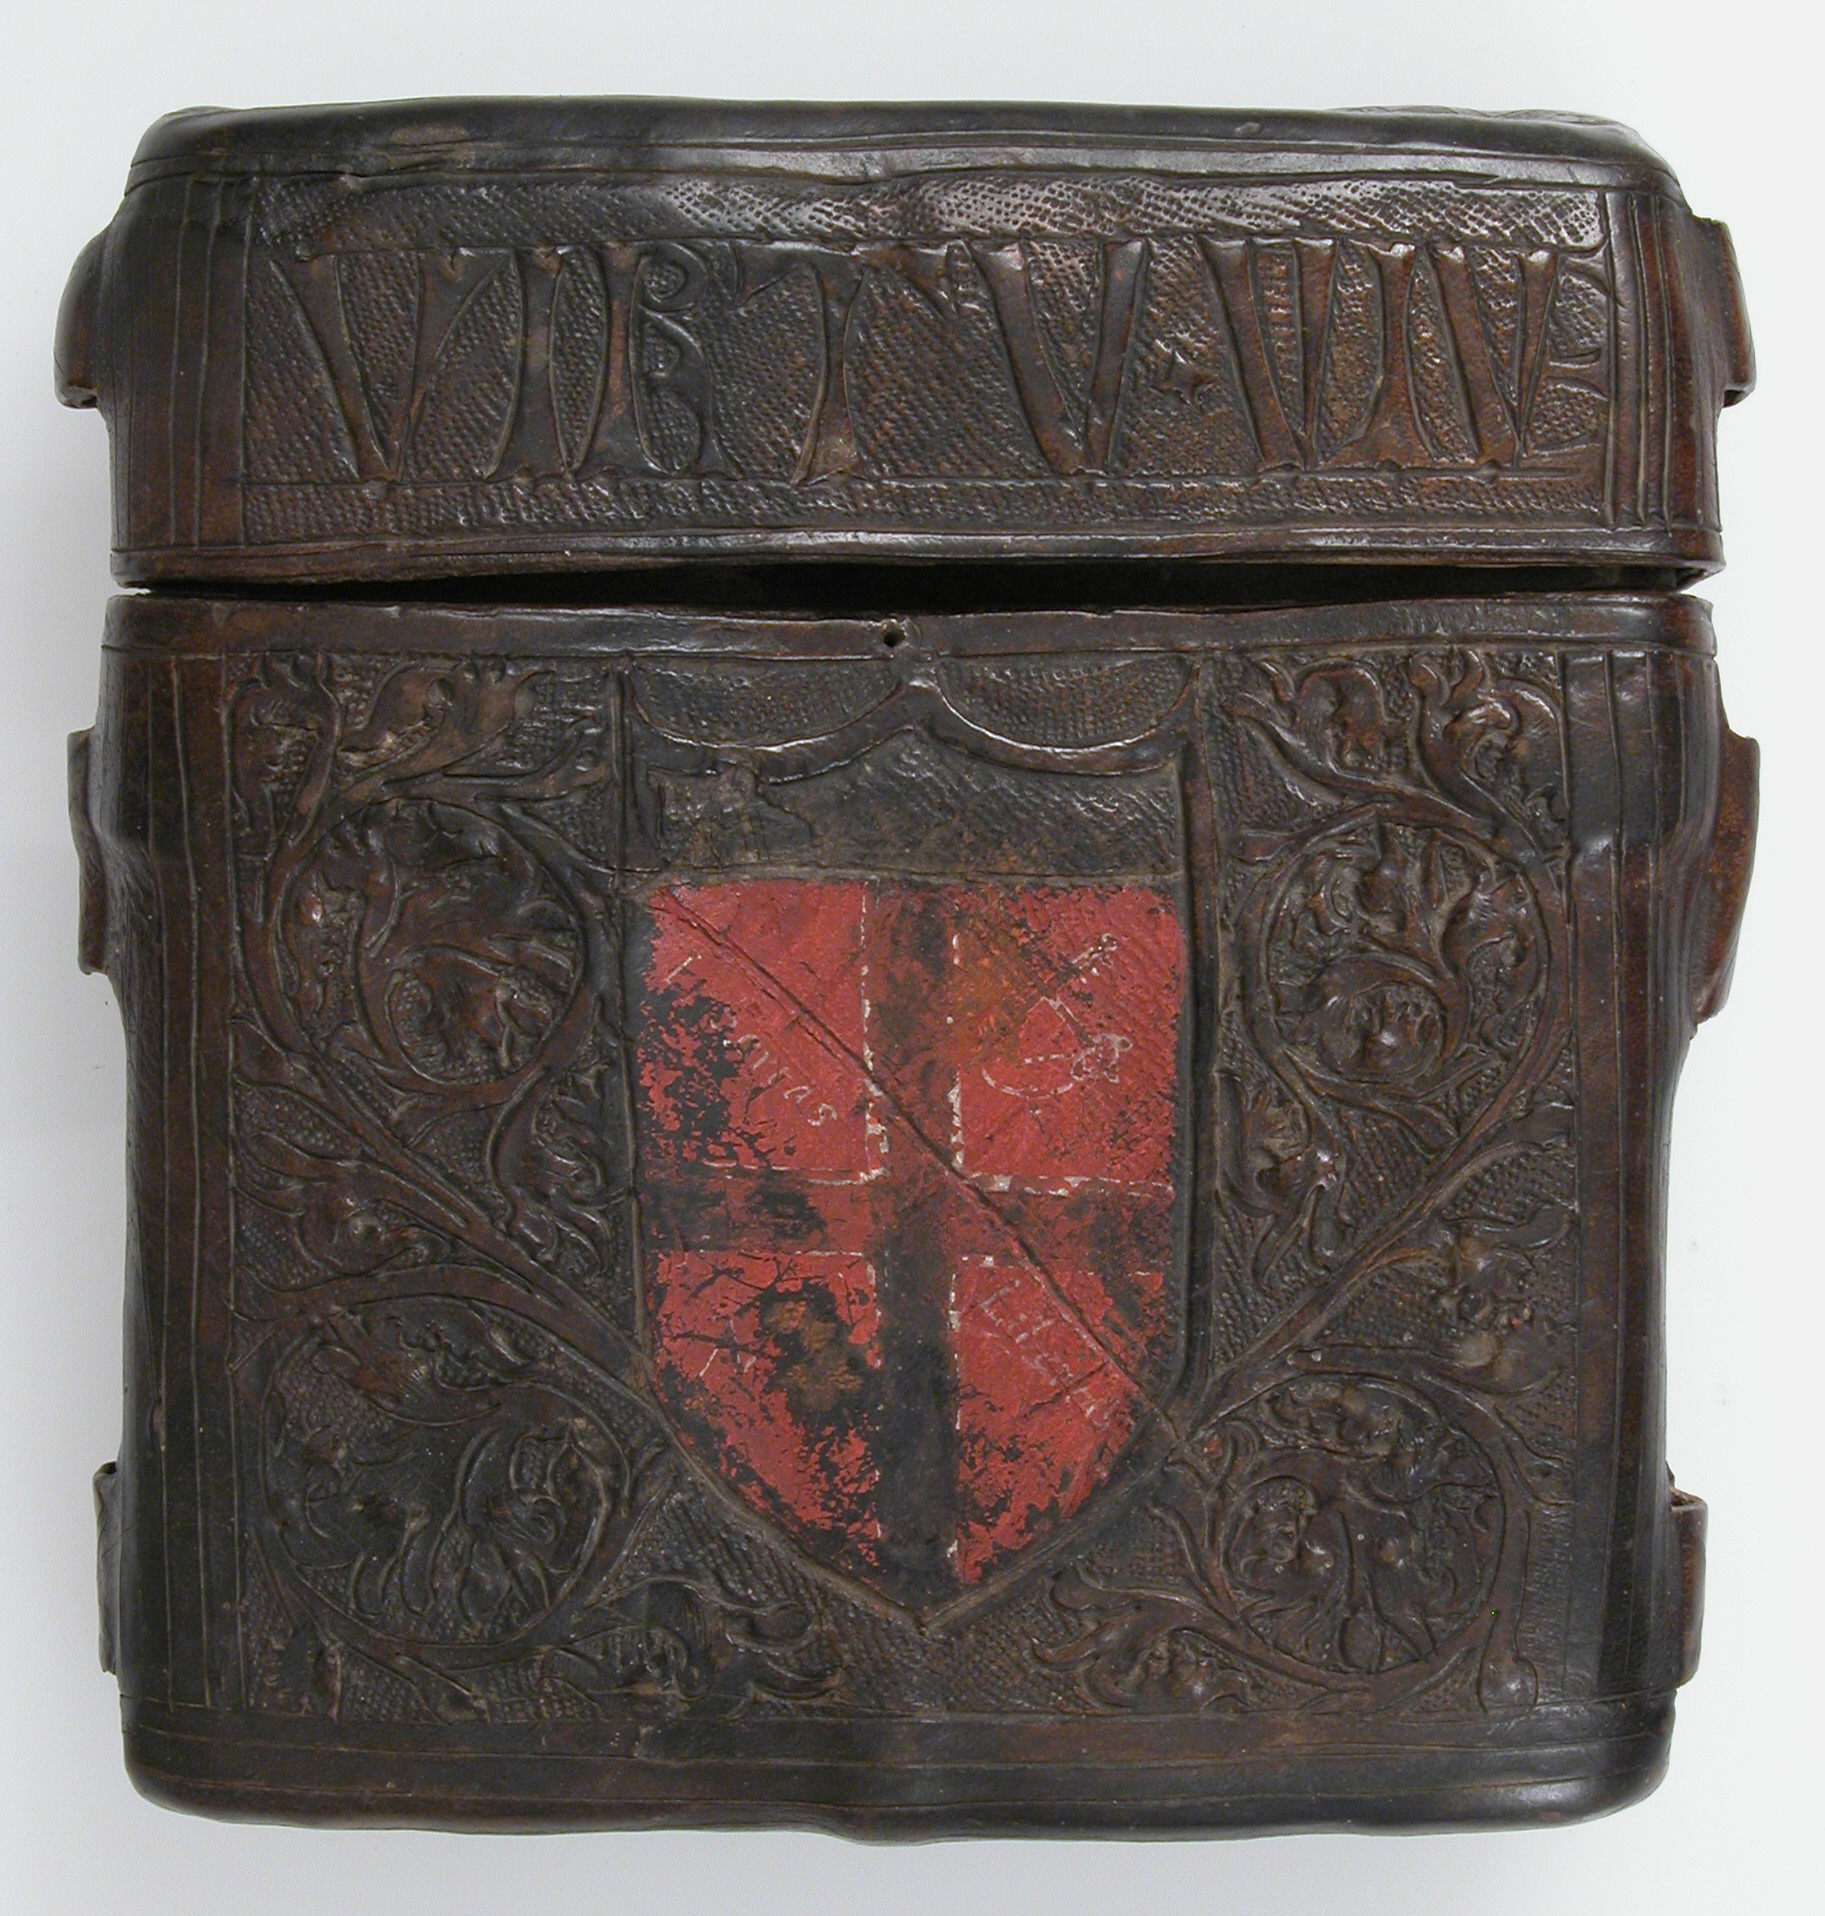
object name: book case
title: Book Box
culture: italian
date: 1401-1500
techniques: polychromy, tooling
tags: coat of arms